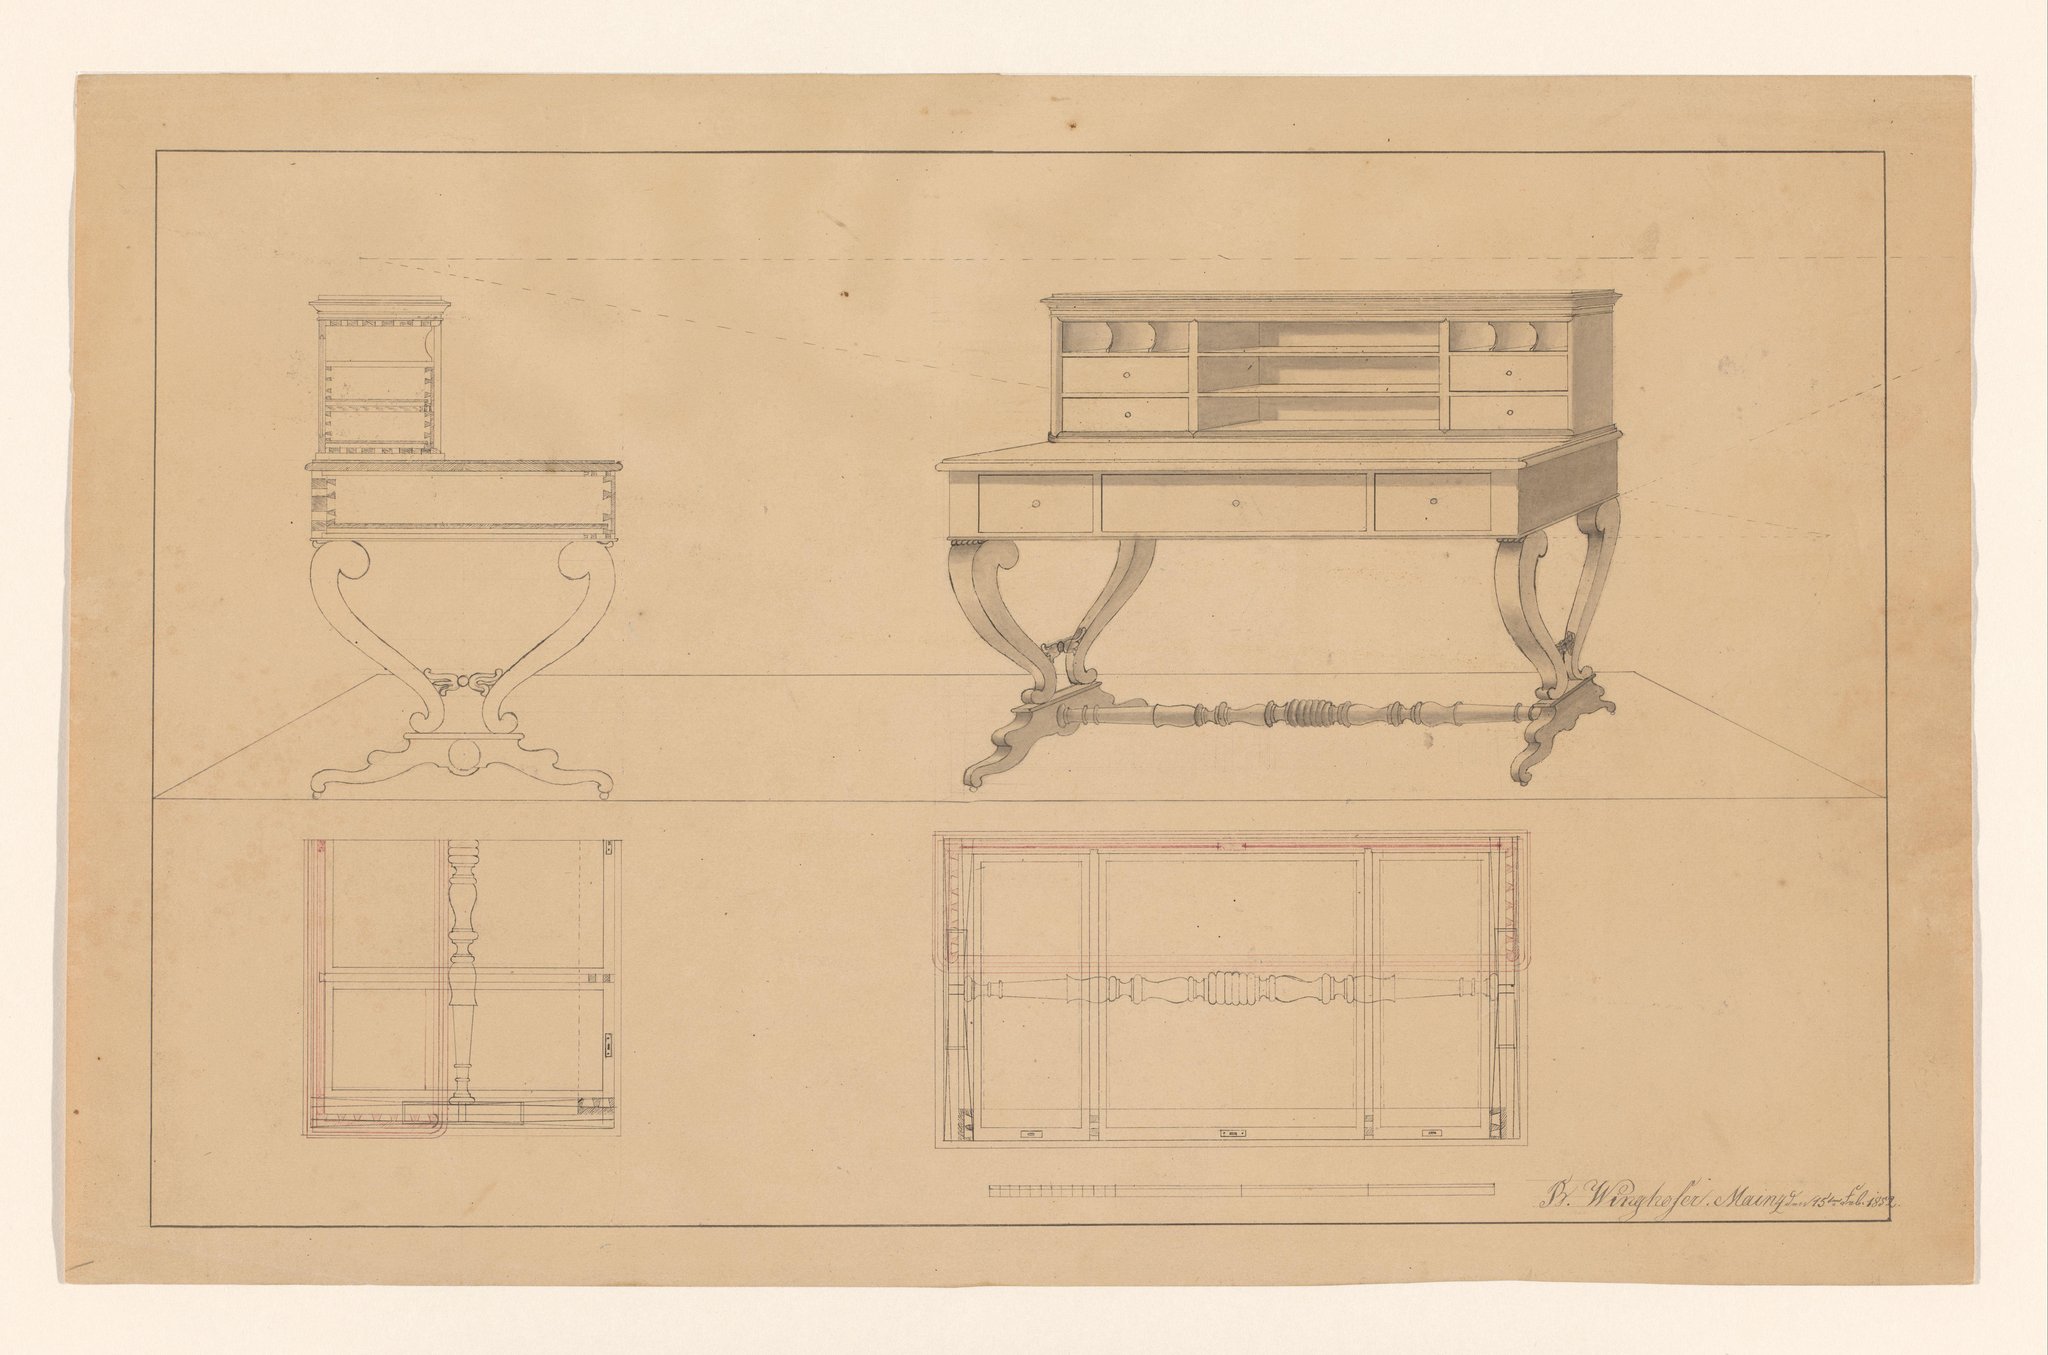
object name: drawing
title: Ontwerp voor een schrijftafel met opstand, met zijaanzicht en plattegronden onder beide aanzichten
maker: b. winghofer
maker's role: draughtsman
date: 1852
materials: graphite, ink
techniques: drawing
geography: mainz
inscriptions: signature and date: ‘B. Winghofer. Mainz den 15ten Feb. 1852’, size: ‘maatstaf’